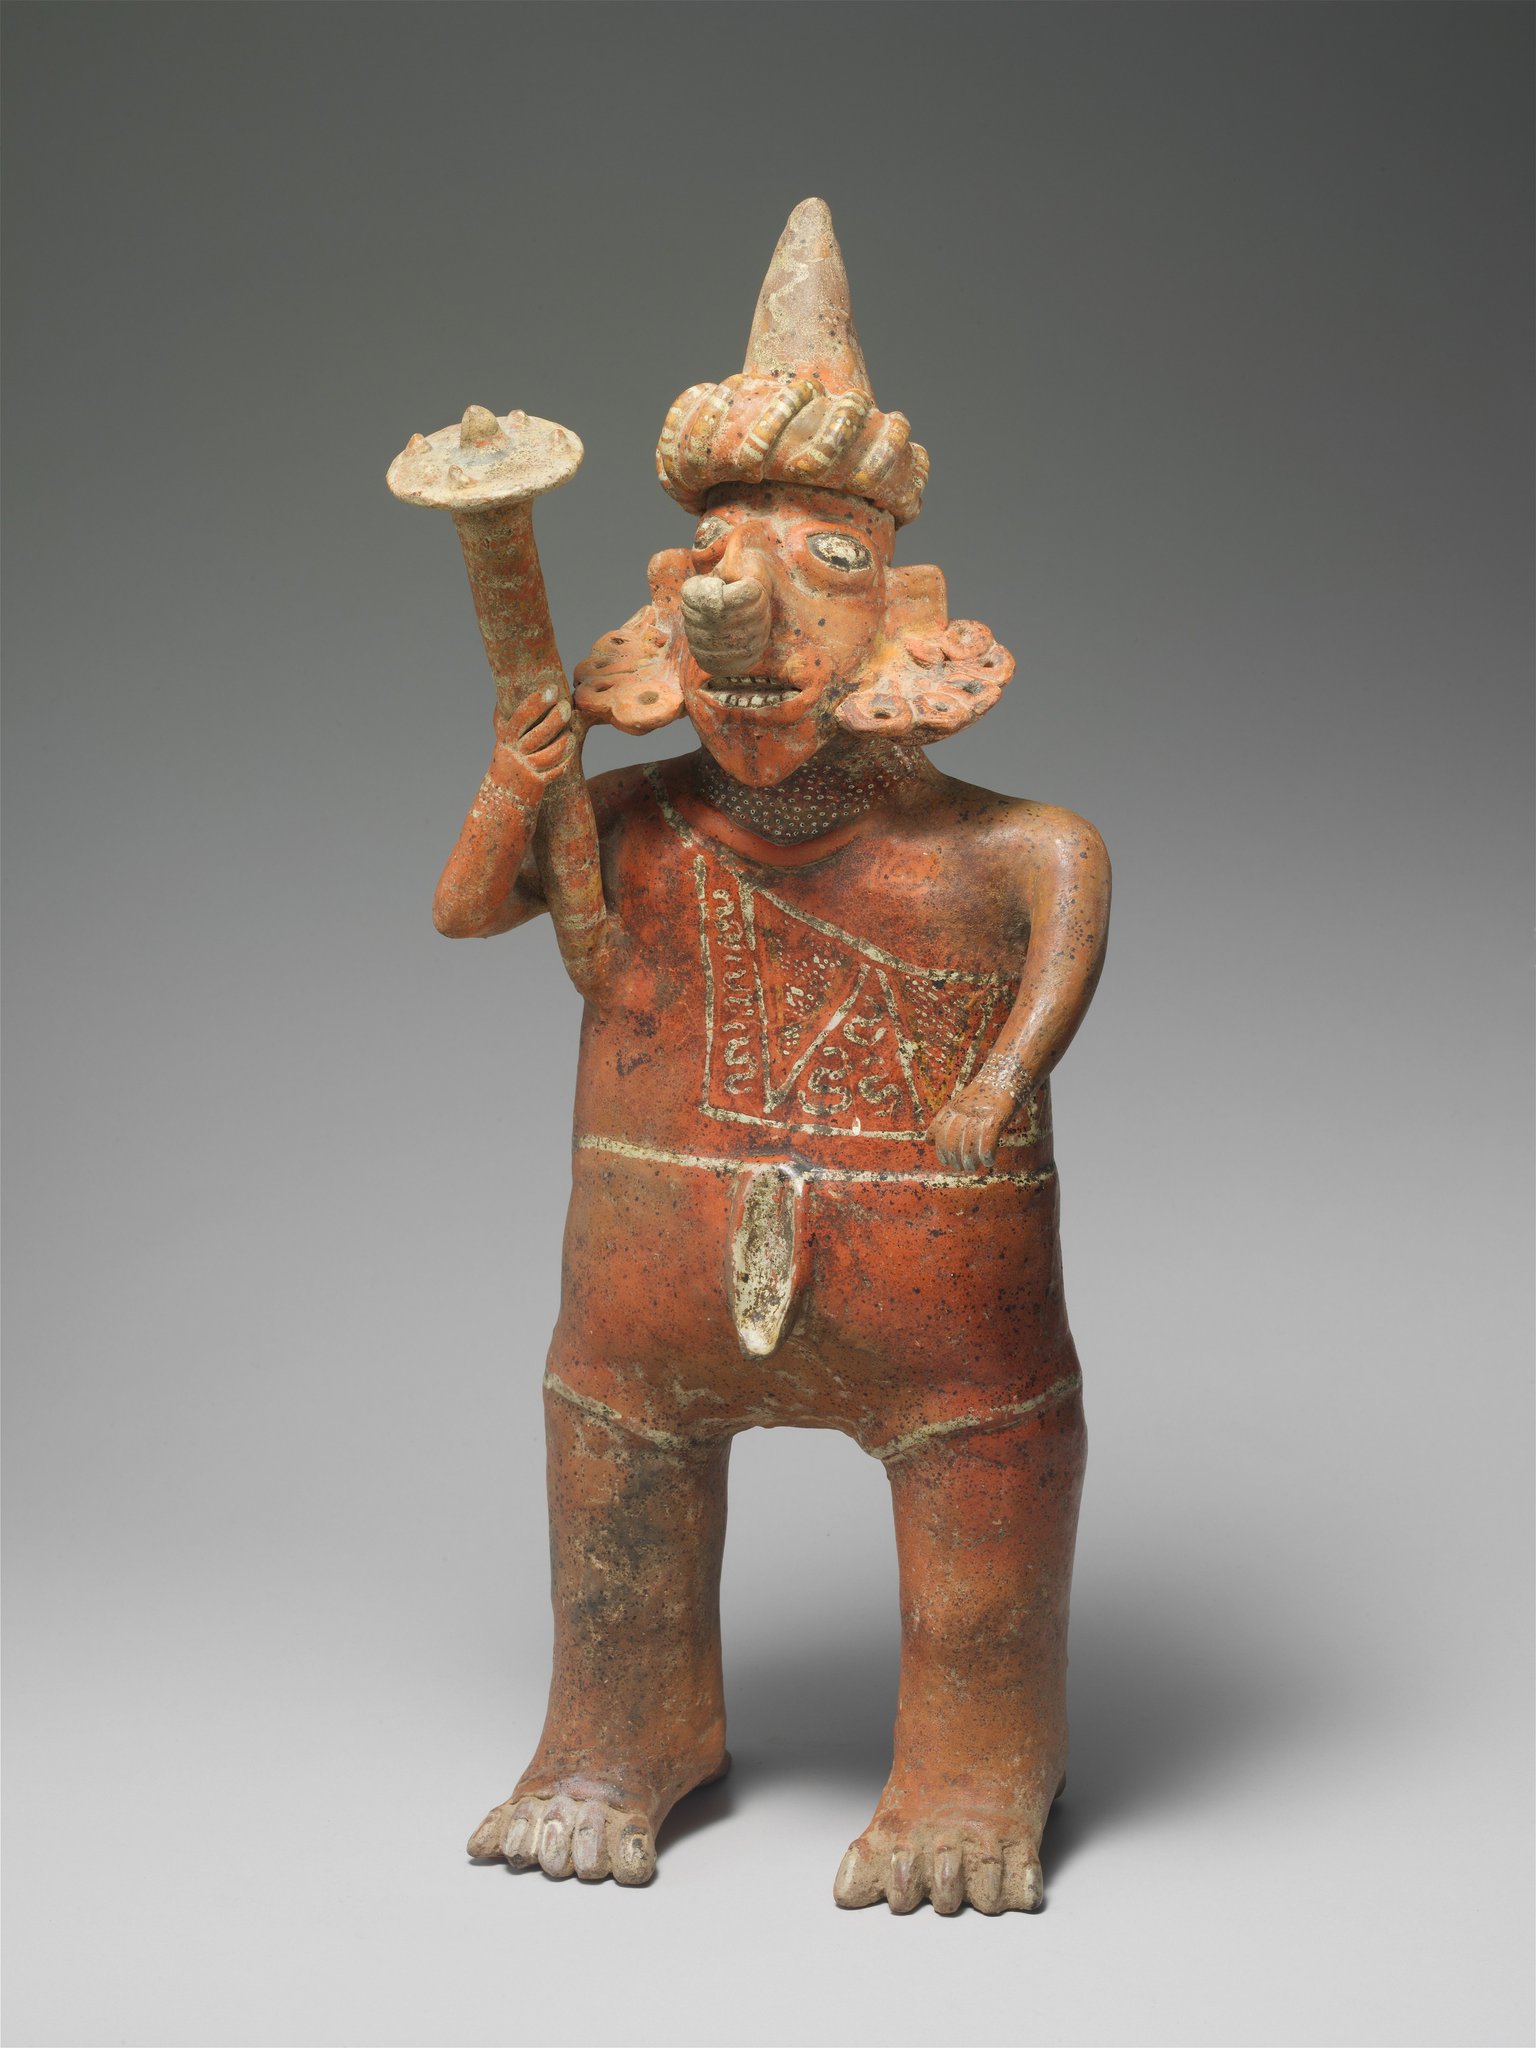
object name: male figure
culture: nayarit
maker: ixtlán del río artist(s)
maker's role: artist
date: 200 BCE-200 CE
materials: ceramic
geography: mexico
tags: men